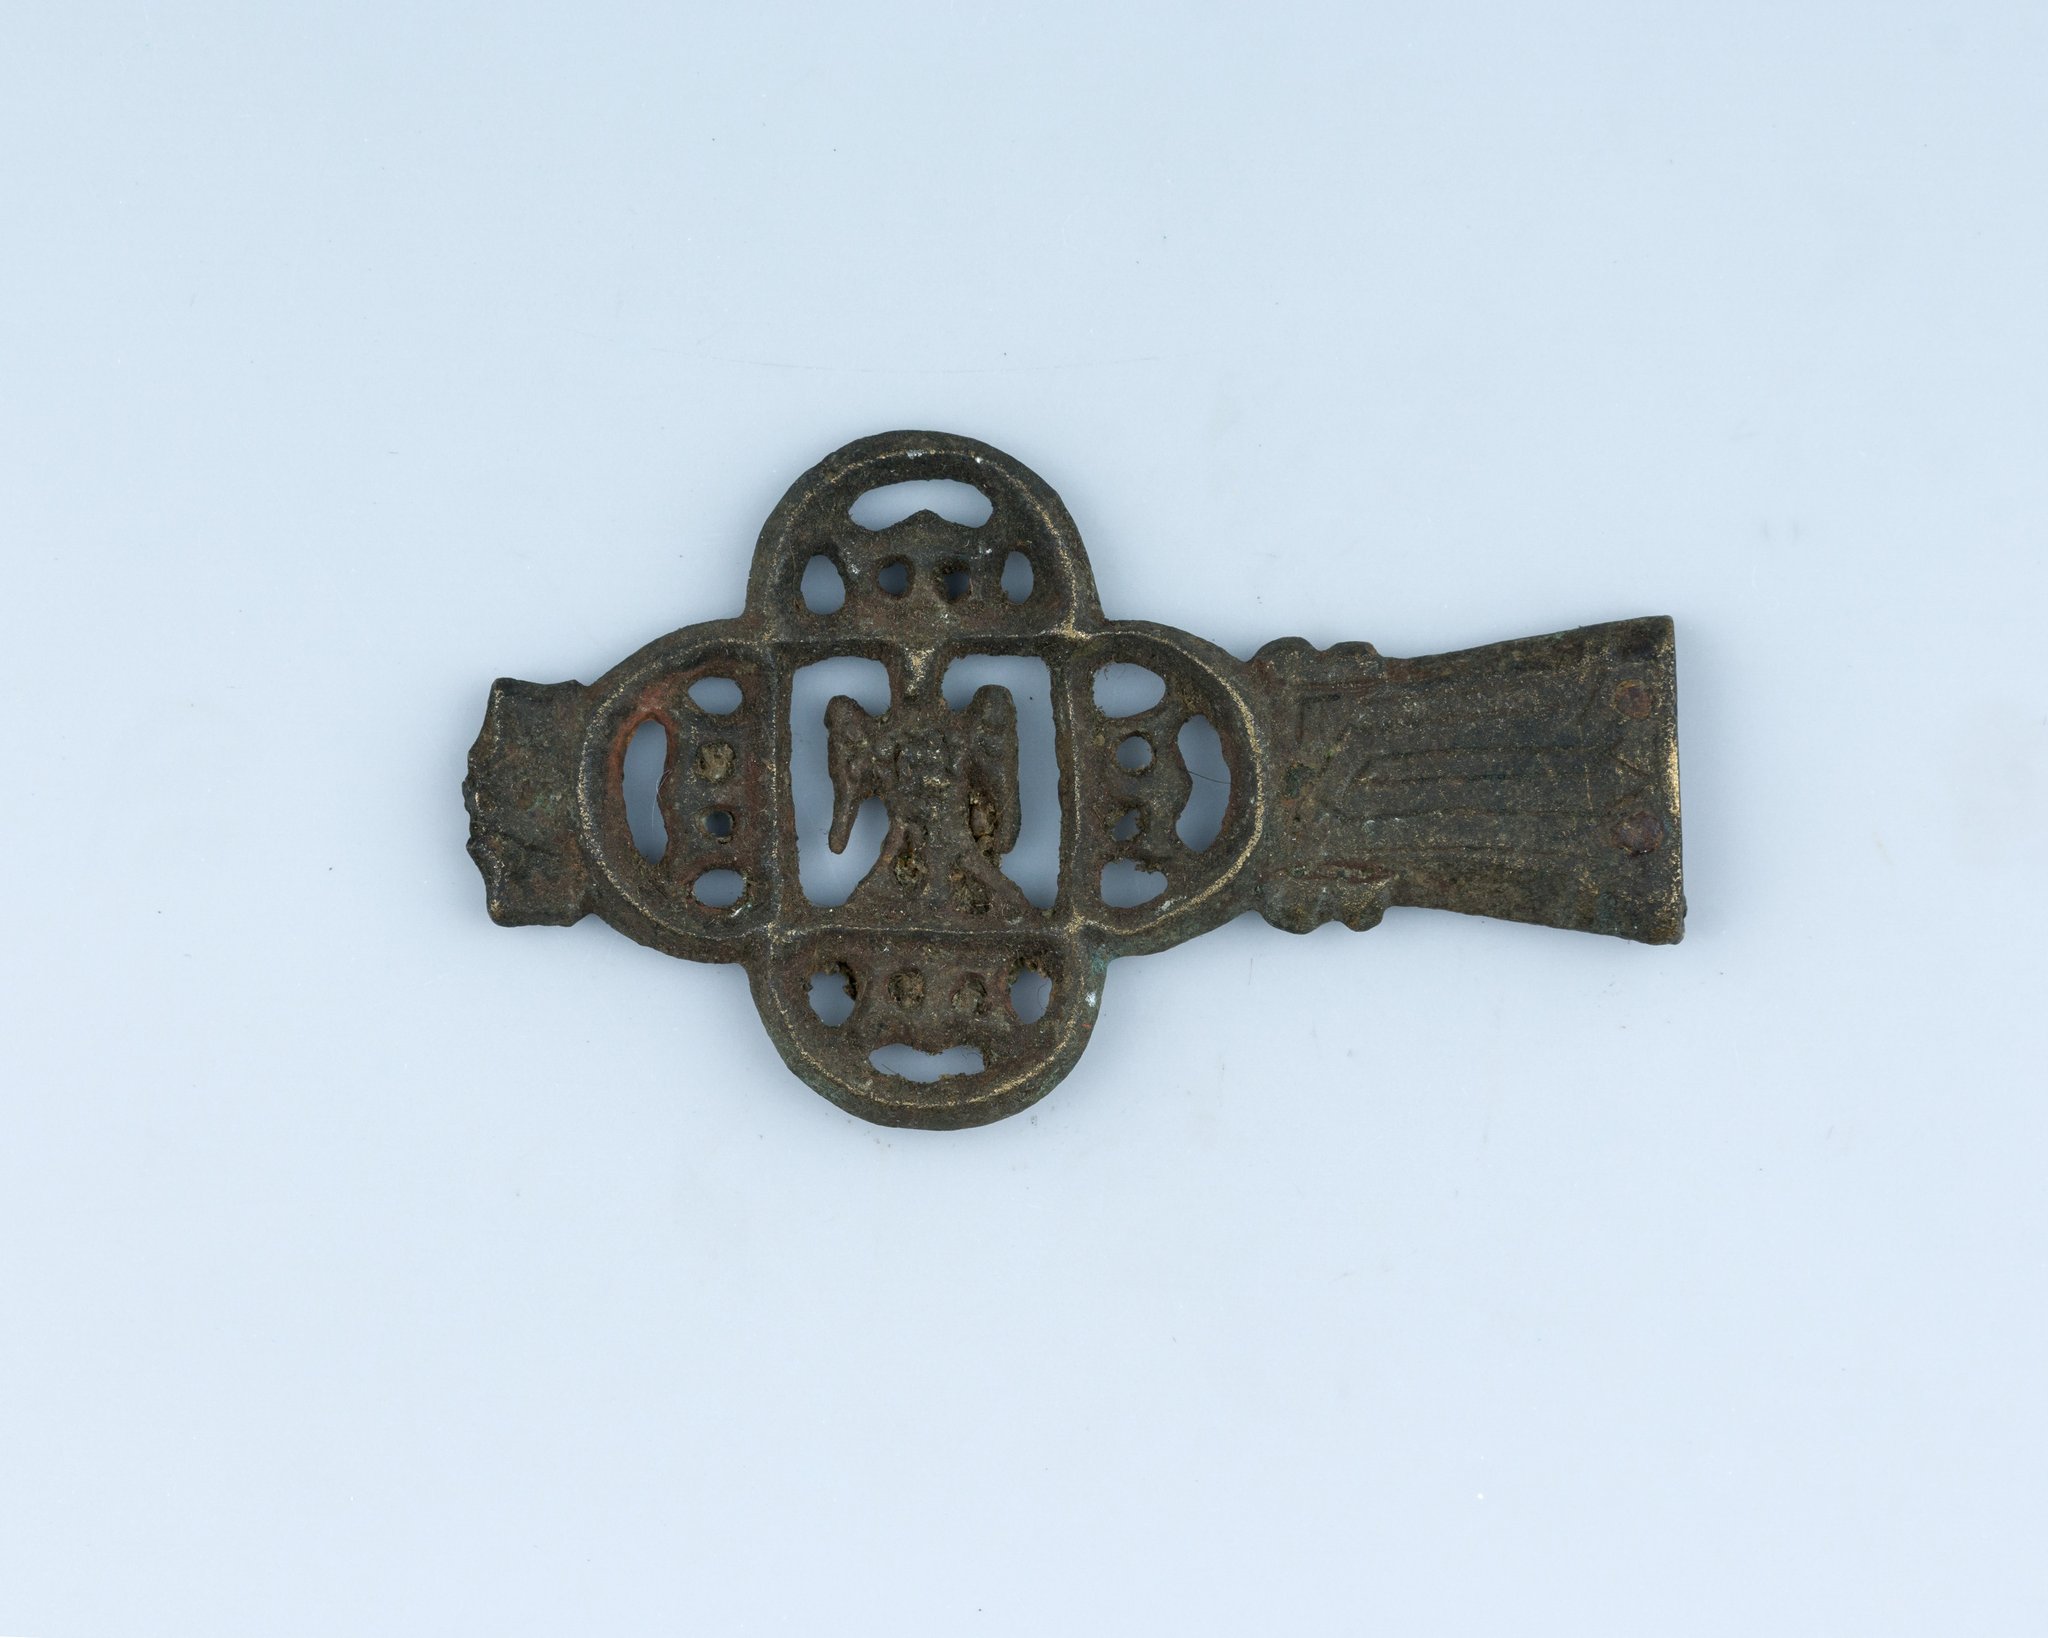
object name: pendant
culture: european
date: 1401-1700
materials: bronze, gilt